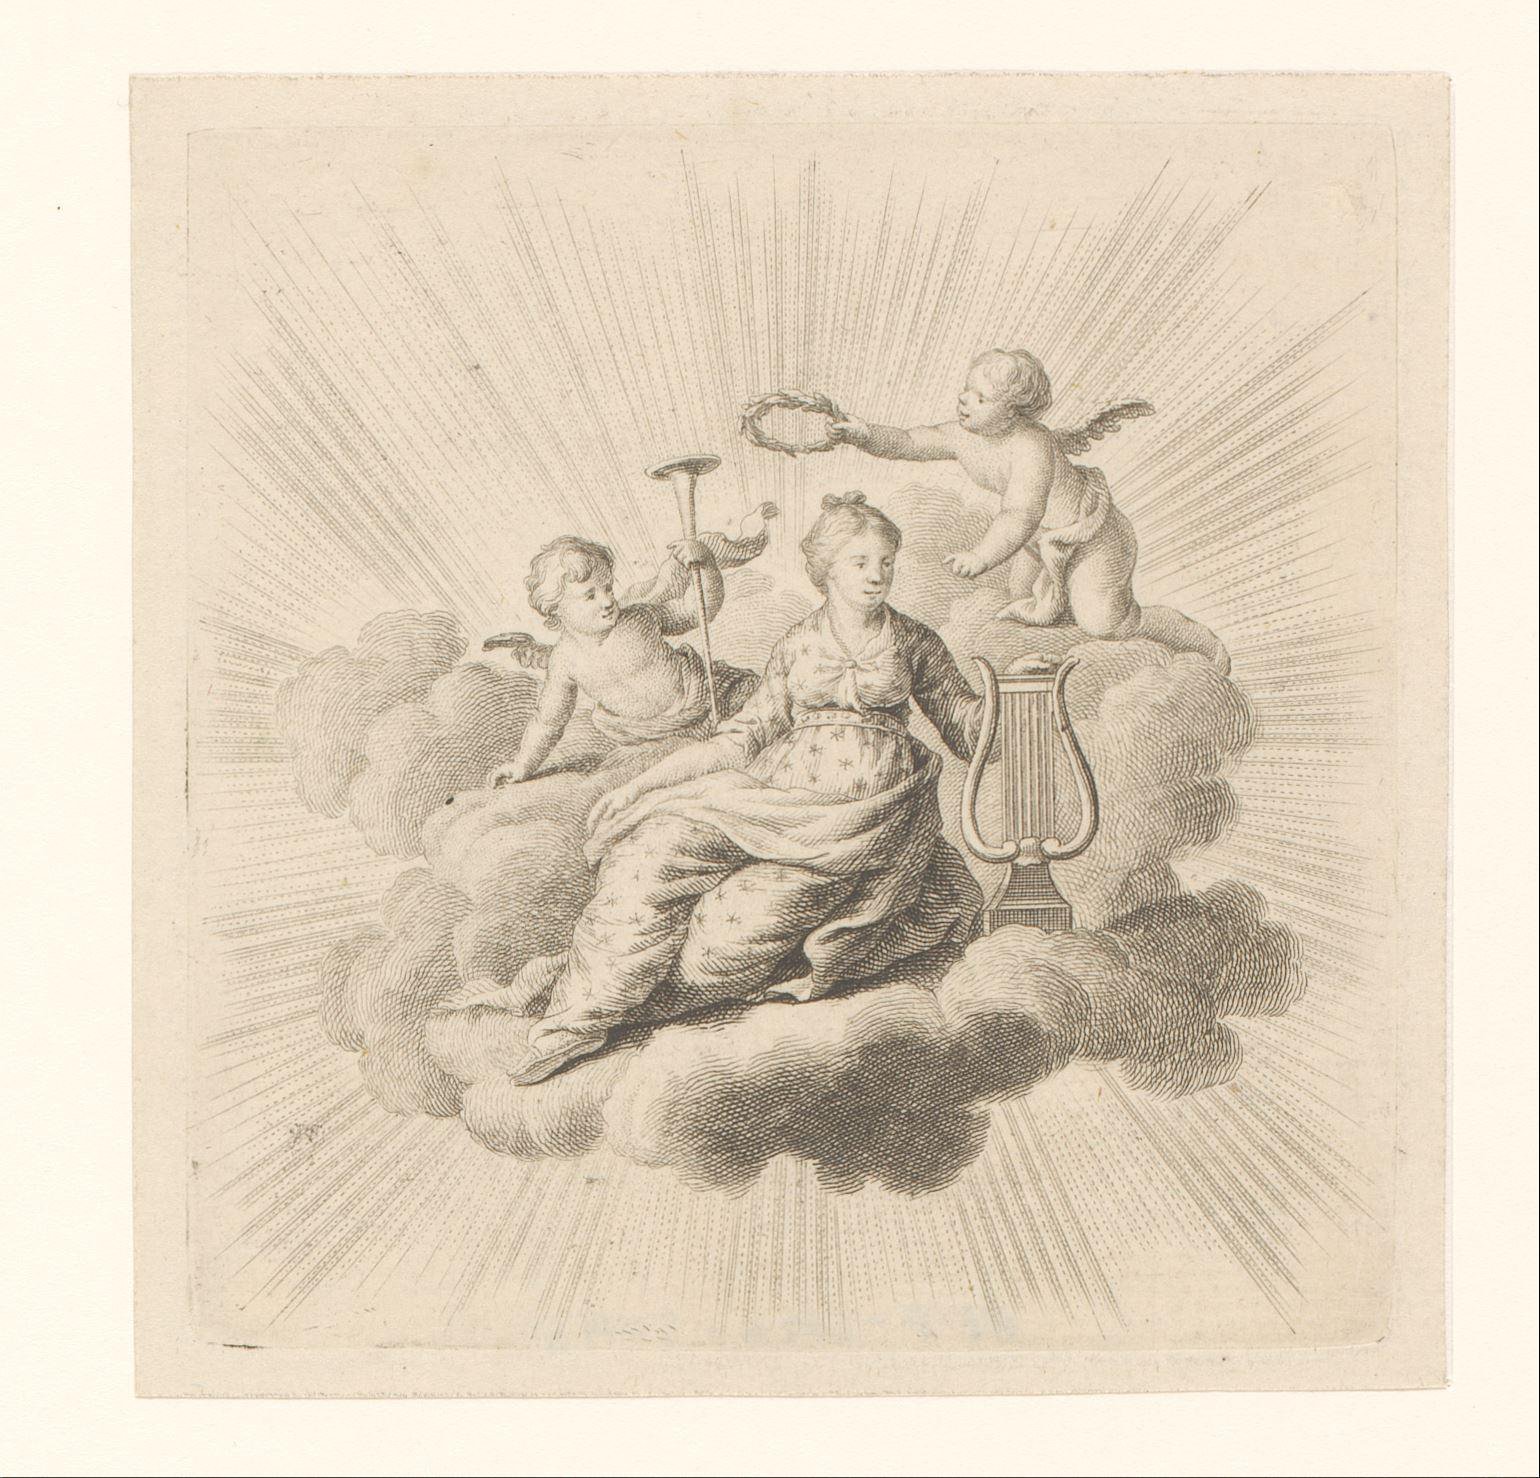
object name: vignette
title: Vignet met vrouw met lier en twee putti op een wolk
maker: Anonymous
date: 1778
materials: paper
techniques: etching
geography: netherlands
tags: lyre, cithara, psaltery, sitting or standing on clouds - aa - female human figure, crowning with laurel, vignette, cupids: 'amores', 'amoretti', 'putti'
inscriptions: collector's mark: Lugt 5007, inscription: ‘Titelvignet van "Adriani van Royen, Poëmata./ Lugduni Batavorum,/ Sumptibus Auctoris, 1778’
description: De putto links houdt een loftrompet vast, terwijl de andere putto de vrouw kroont met een lauwerkrans.